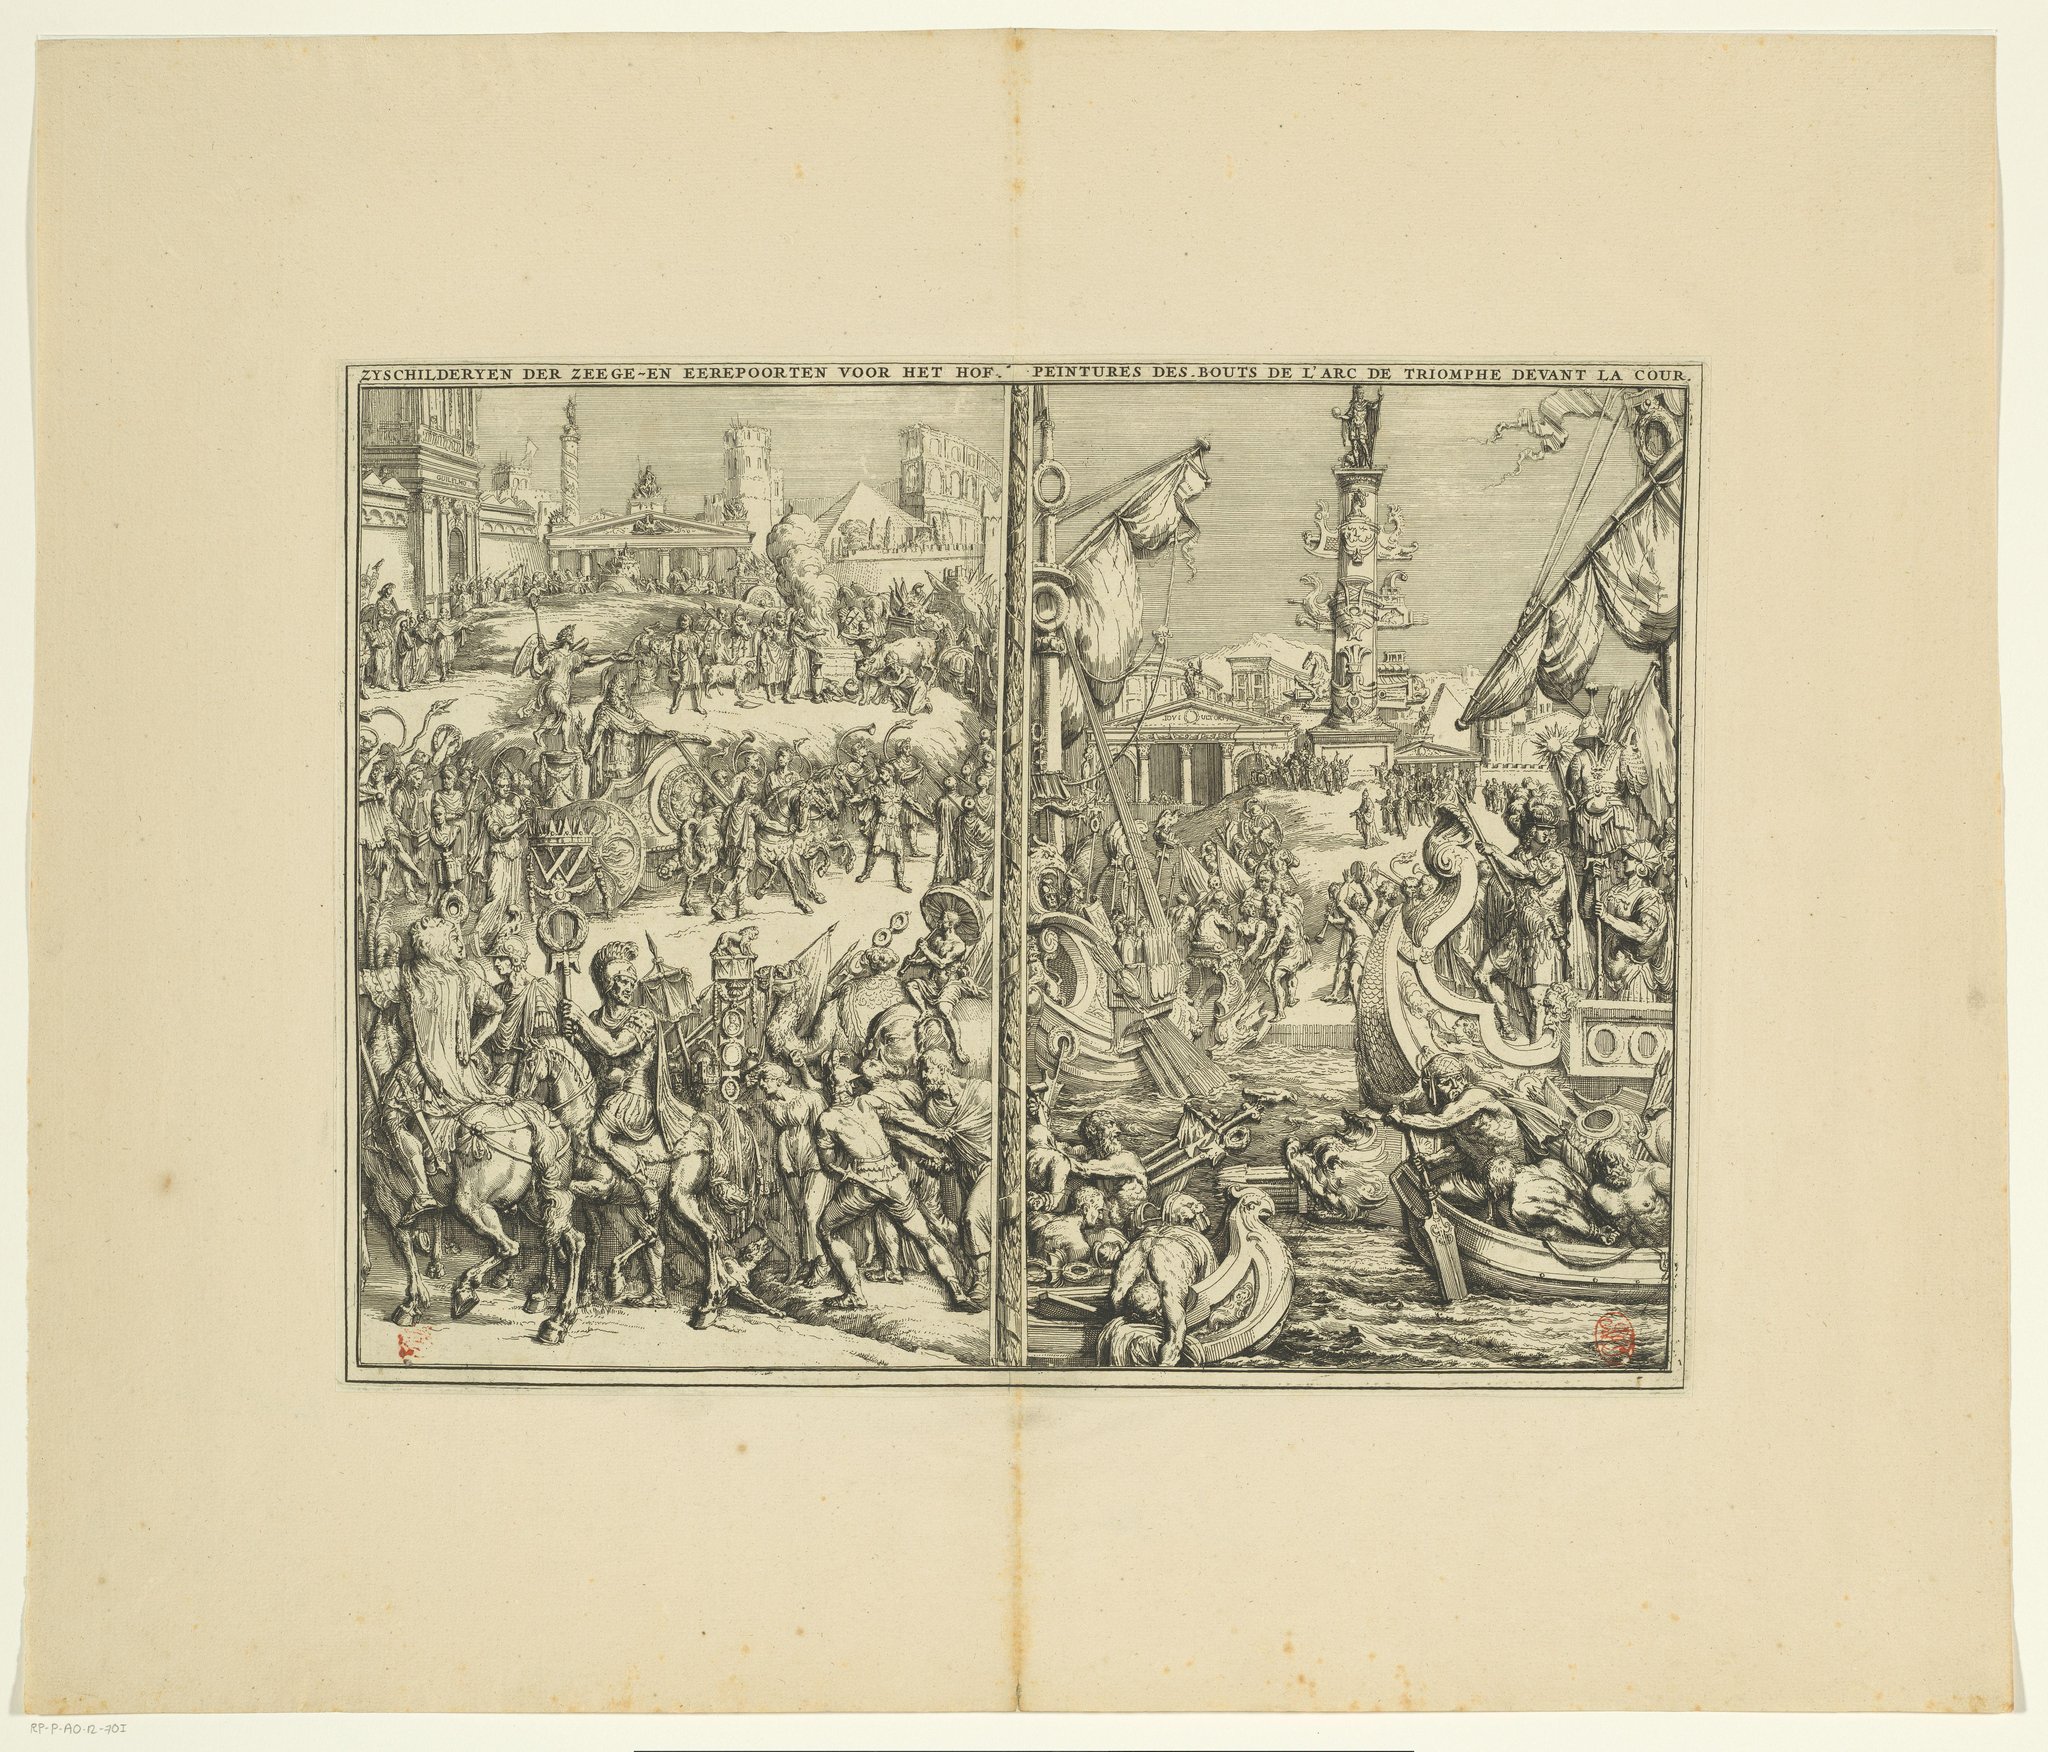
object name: print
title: Twee schilderijen op de zijden van de triomfbogen voor het Buitenhof, 1691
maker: romeyn de hooghe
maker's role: draughtsman, goldsmith, painter, print maker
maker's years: 1645-1708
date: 1691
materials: paper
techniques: etching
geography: northern netherlands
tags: william iii (prince of orange and king of england, scotland, and ireland), triumphal entry and public reception, pageant, 'entrée solennelle', 'joyeuse entrée'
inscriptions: collector's mark: Lugt 195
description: Prent ook gebruikt in: Bidloo, Govard. Komste van zyne majesteit Willem III. Koning van Groot Britanje, enz. in Holland; ofte omstandelyke beschryving van alles, (…) vercierd met kopere plaaten. Den Haag: Arnoud Leers, 1691.